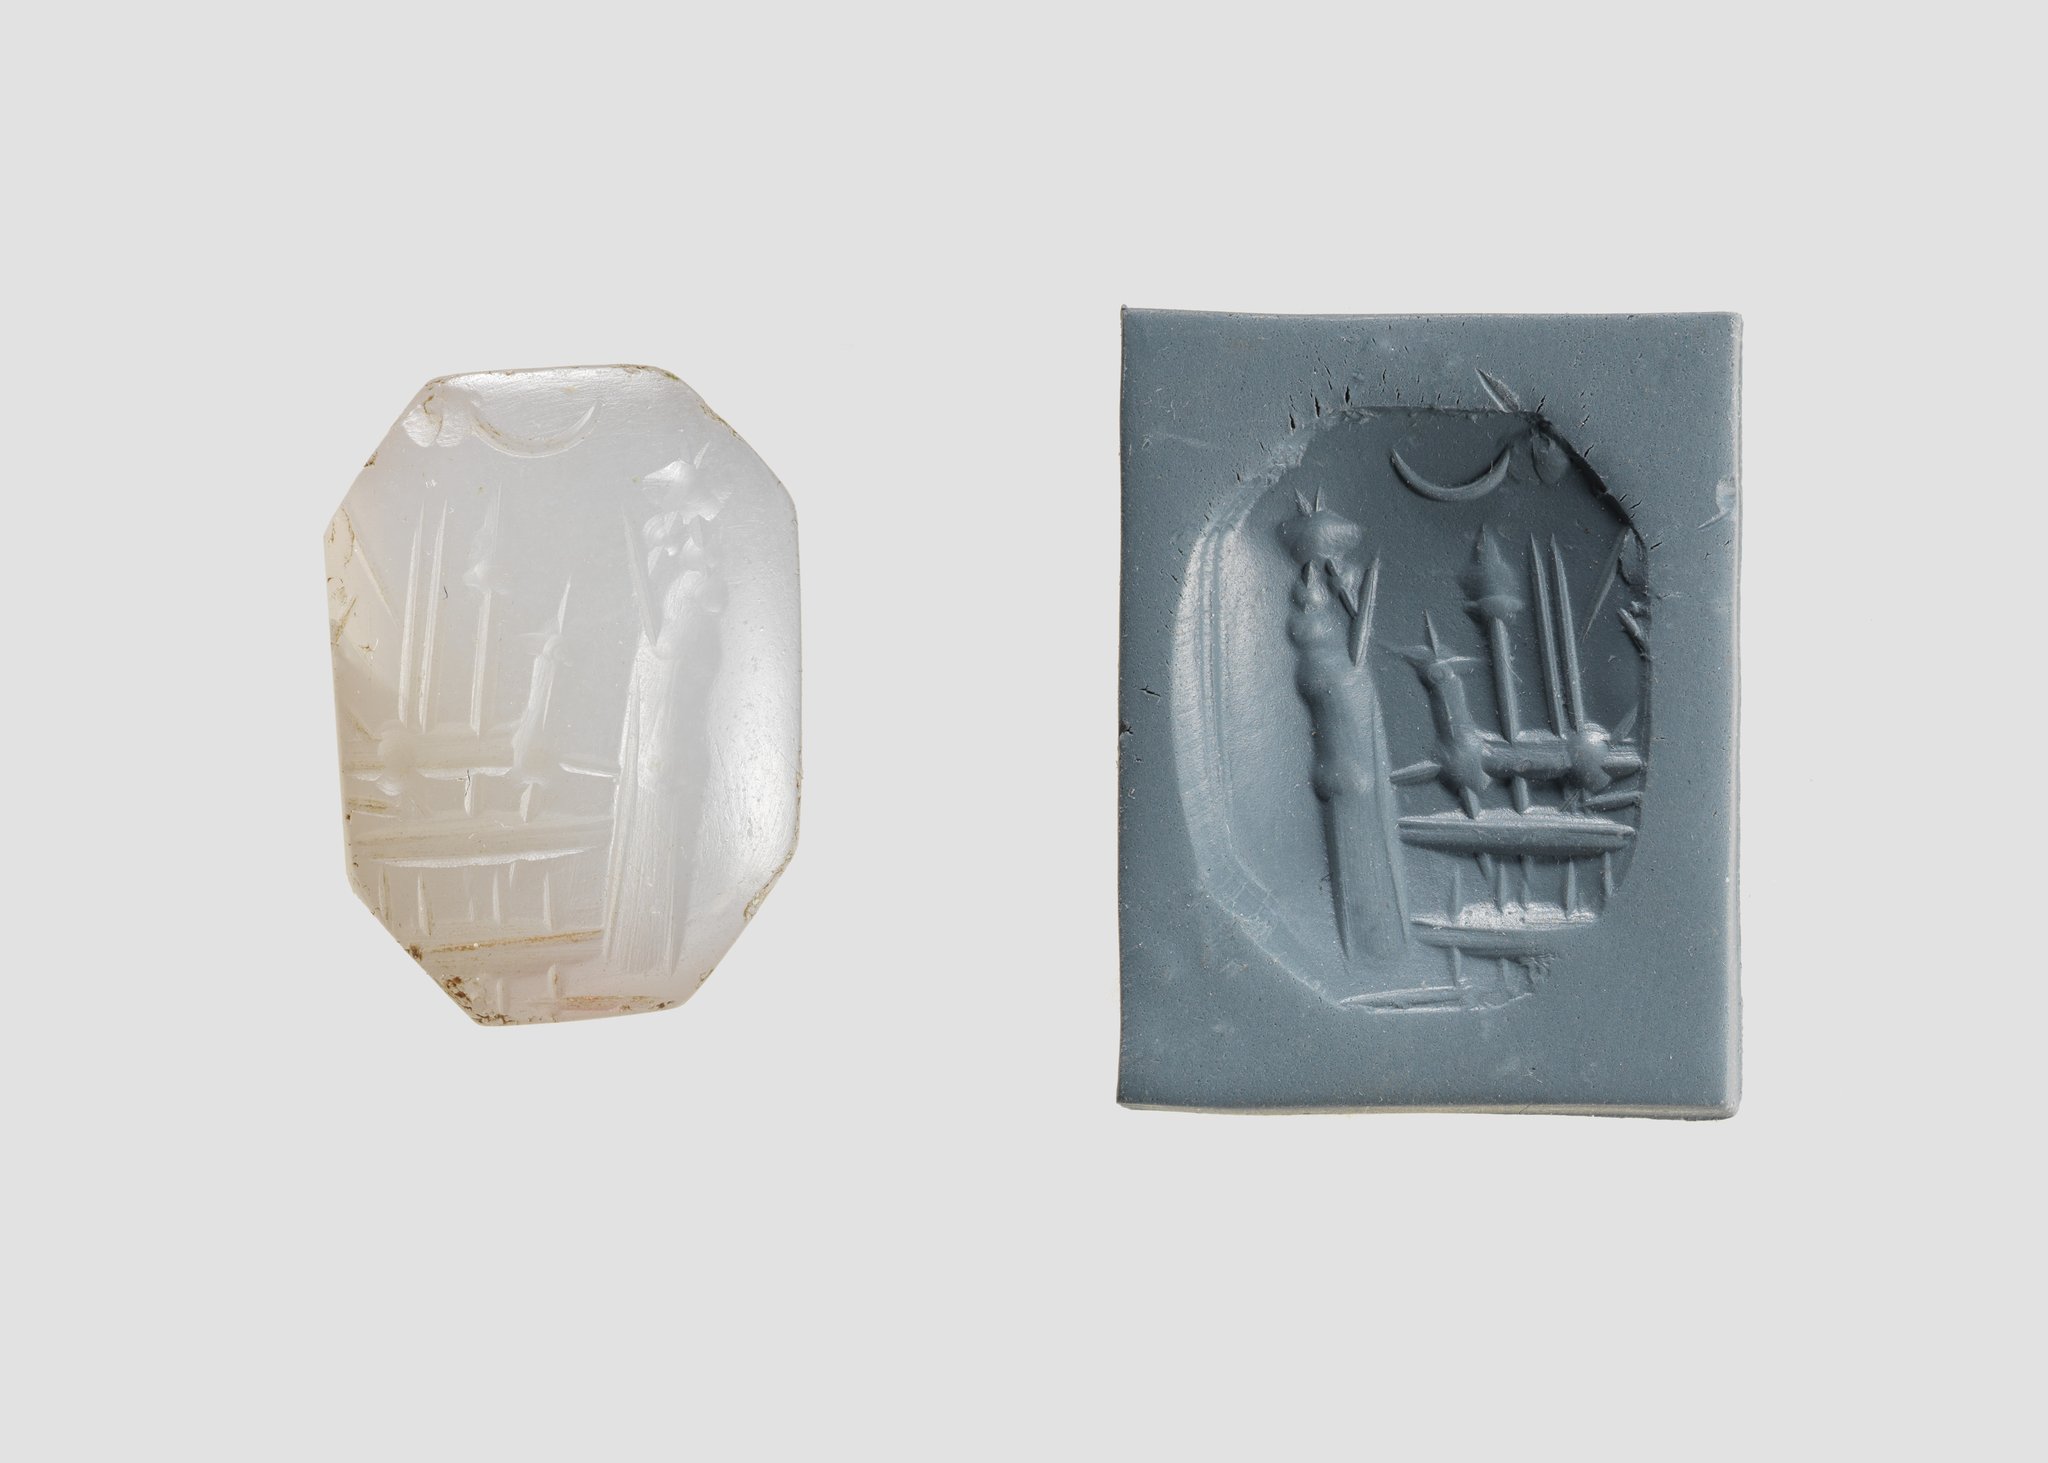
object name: stamp seal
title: Stamp seal (octagonal pyramid) with cultic scene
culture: assyro-babylonian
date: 700-501 BCE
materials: stone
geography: mesopotamia